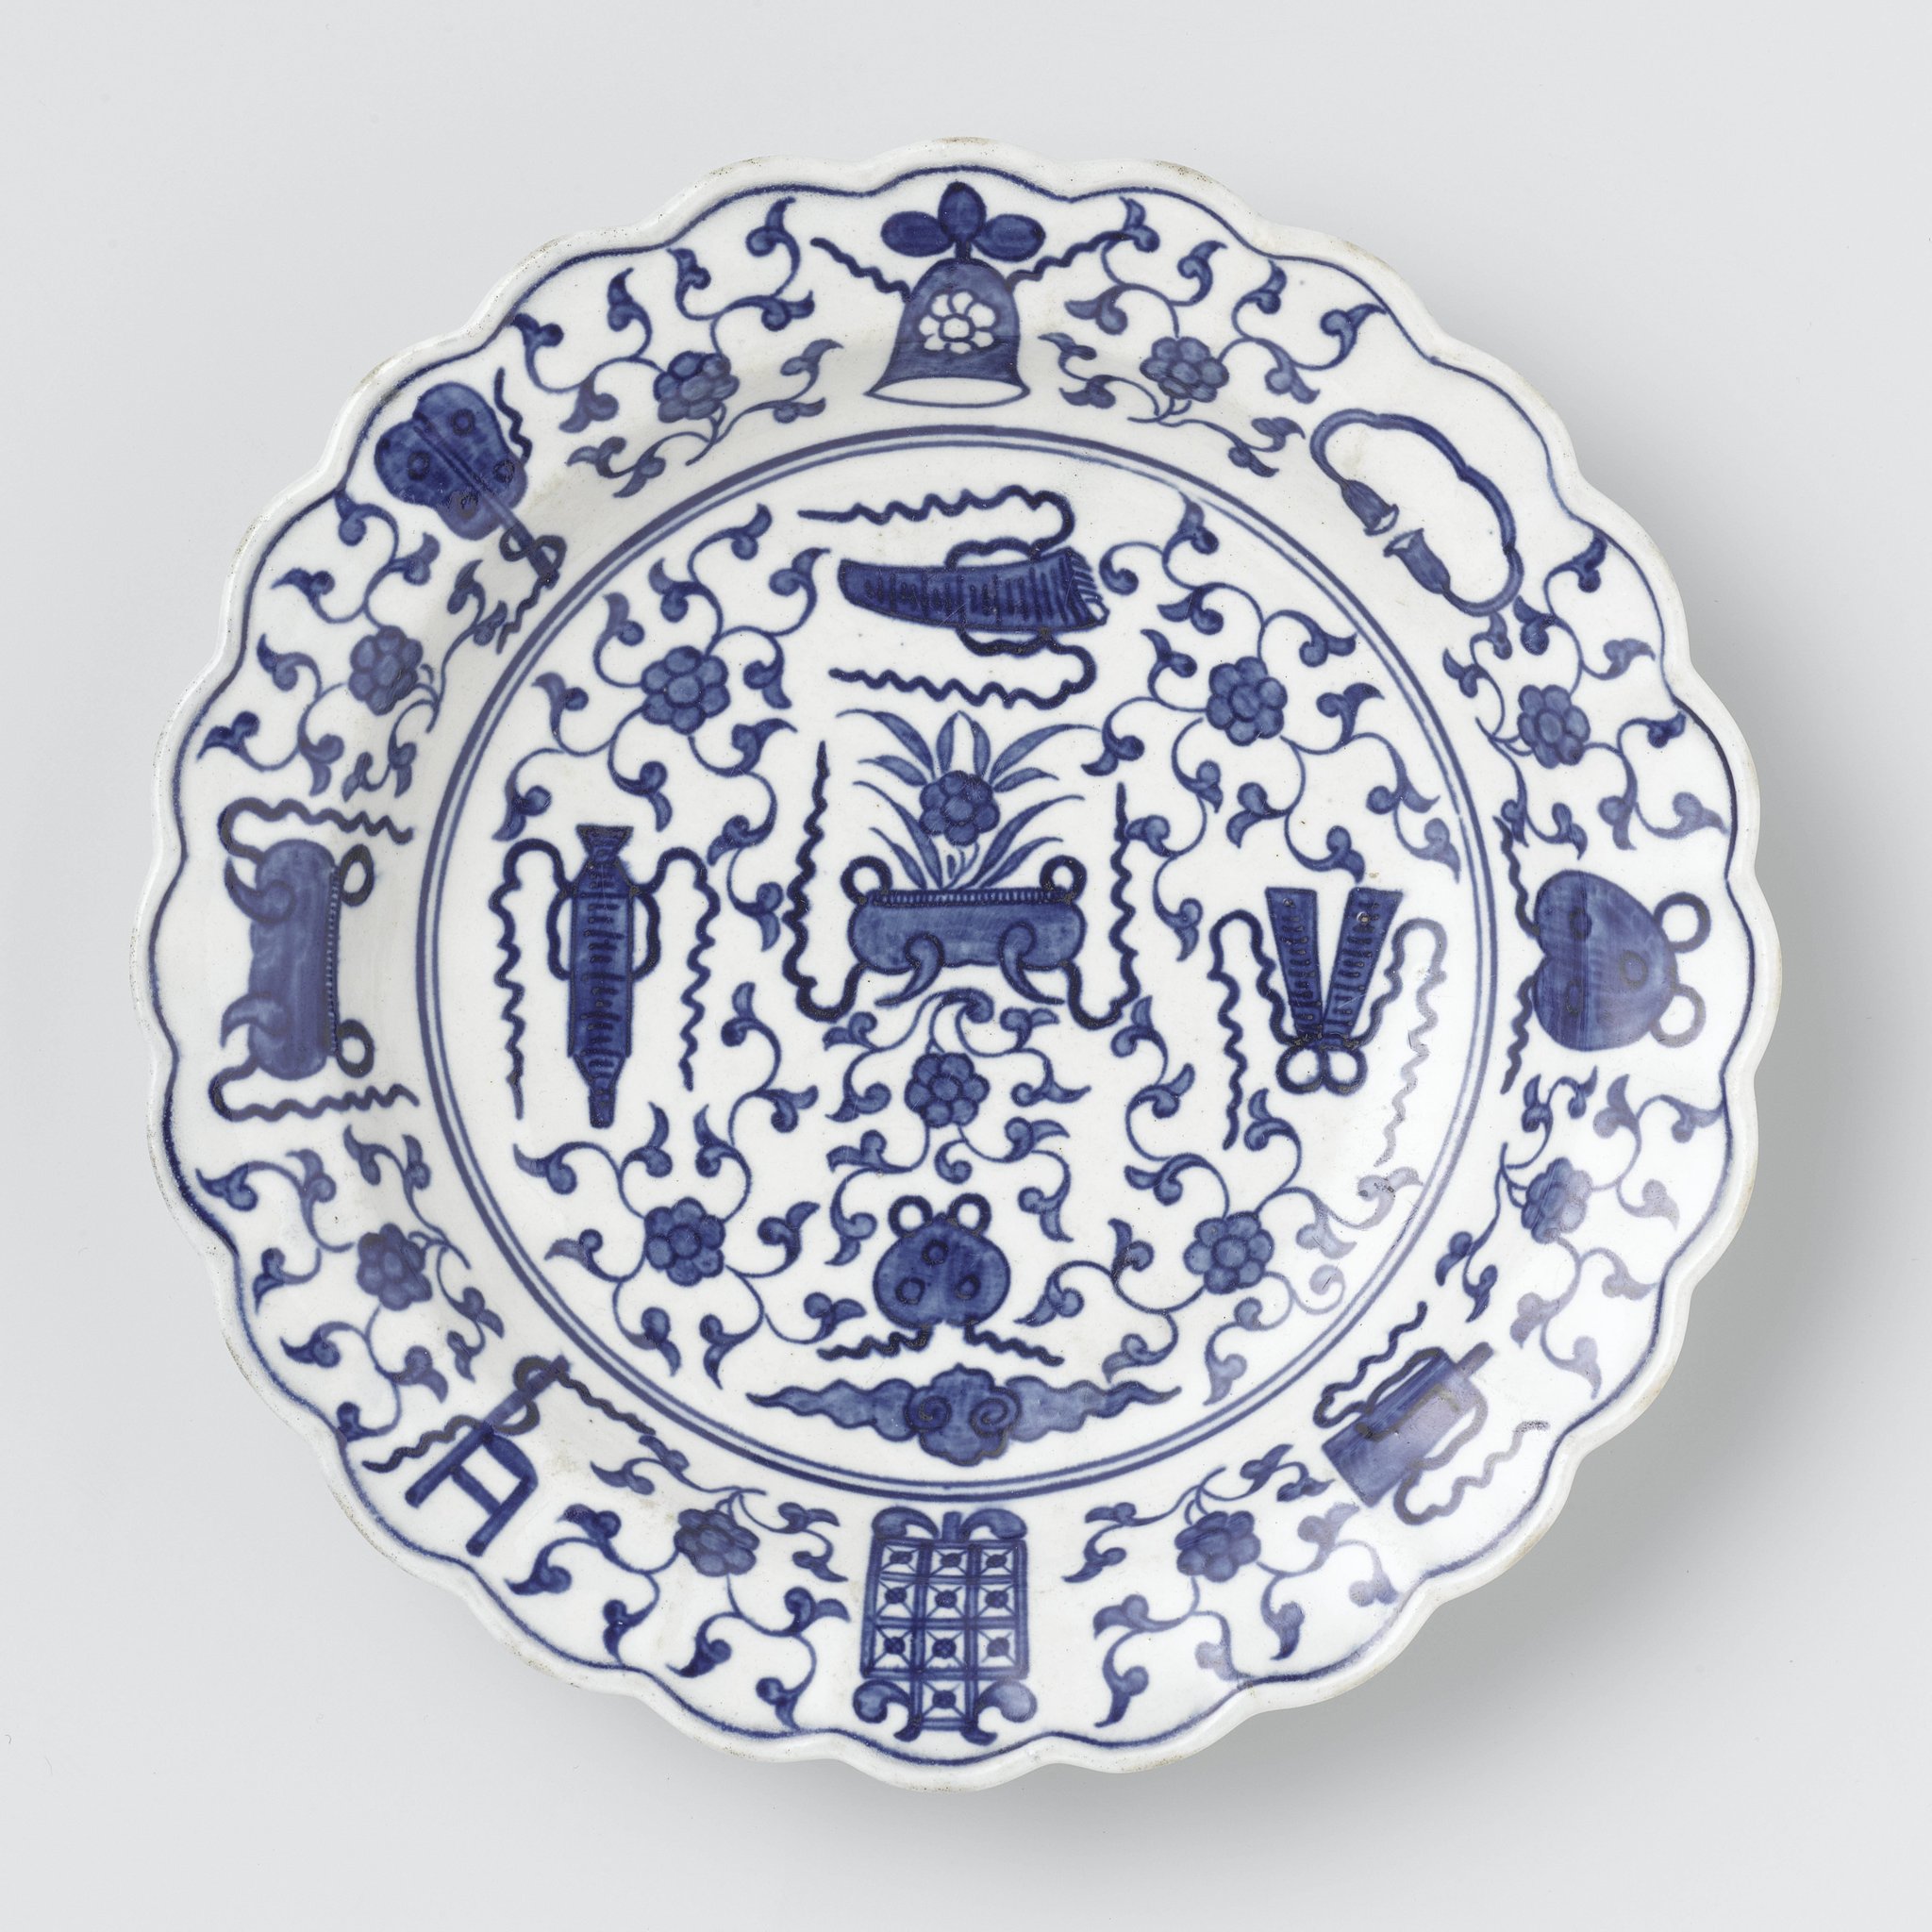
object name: platter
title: Schotel met gekartelde rand en decoratie in blauw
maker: Anonymous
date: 1790-1800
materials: soft paste porcelain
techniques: painted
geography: worcester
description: Schotel van soft paste porcelain, met gekartelde rand en versierd op witte grond met blauw: rand en plat met arabesken en Chinese emblemen. Aan de achterzijde twee dubbele cirkellijnen en een fantastisch geïmproviseerd Chinees merk.